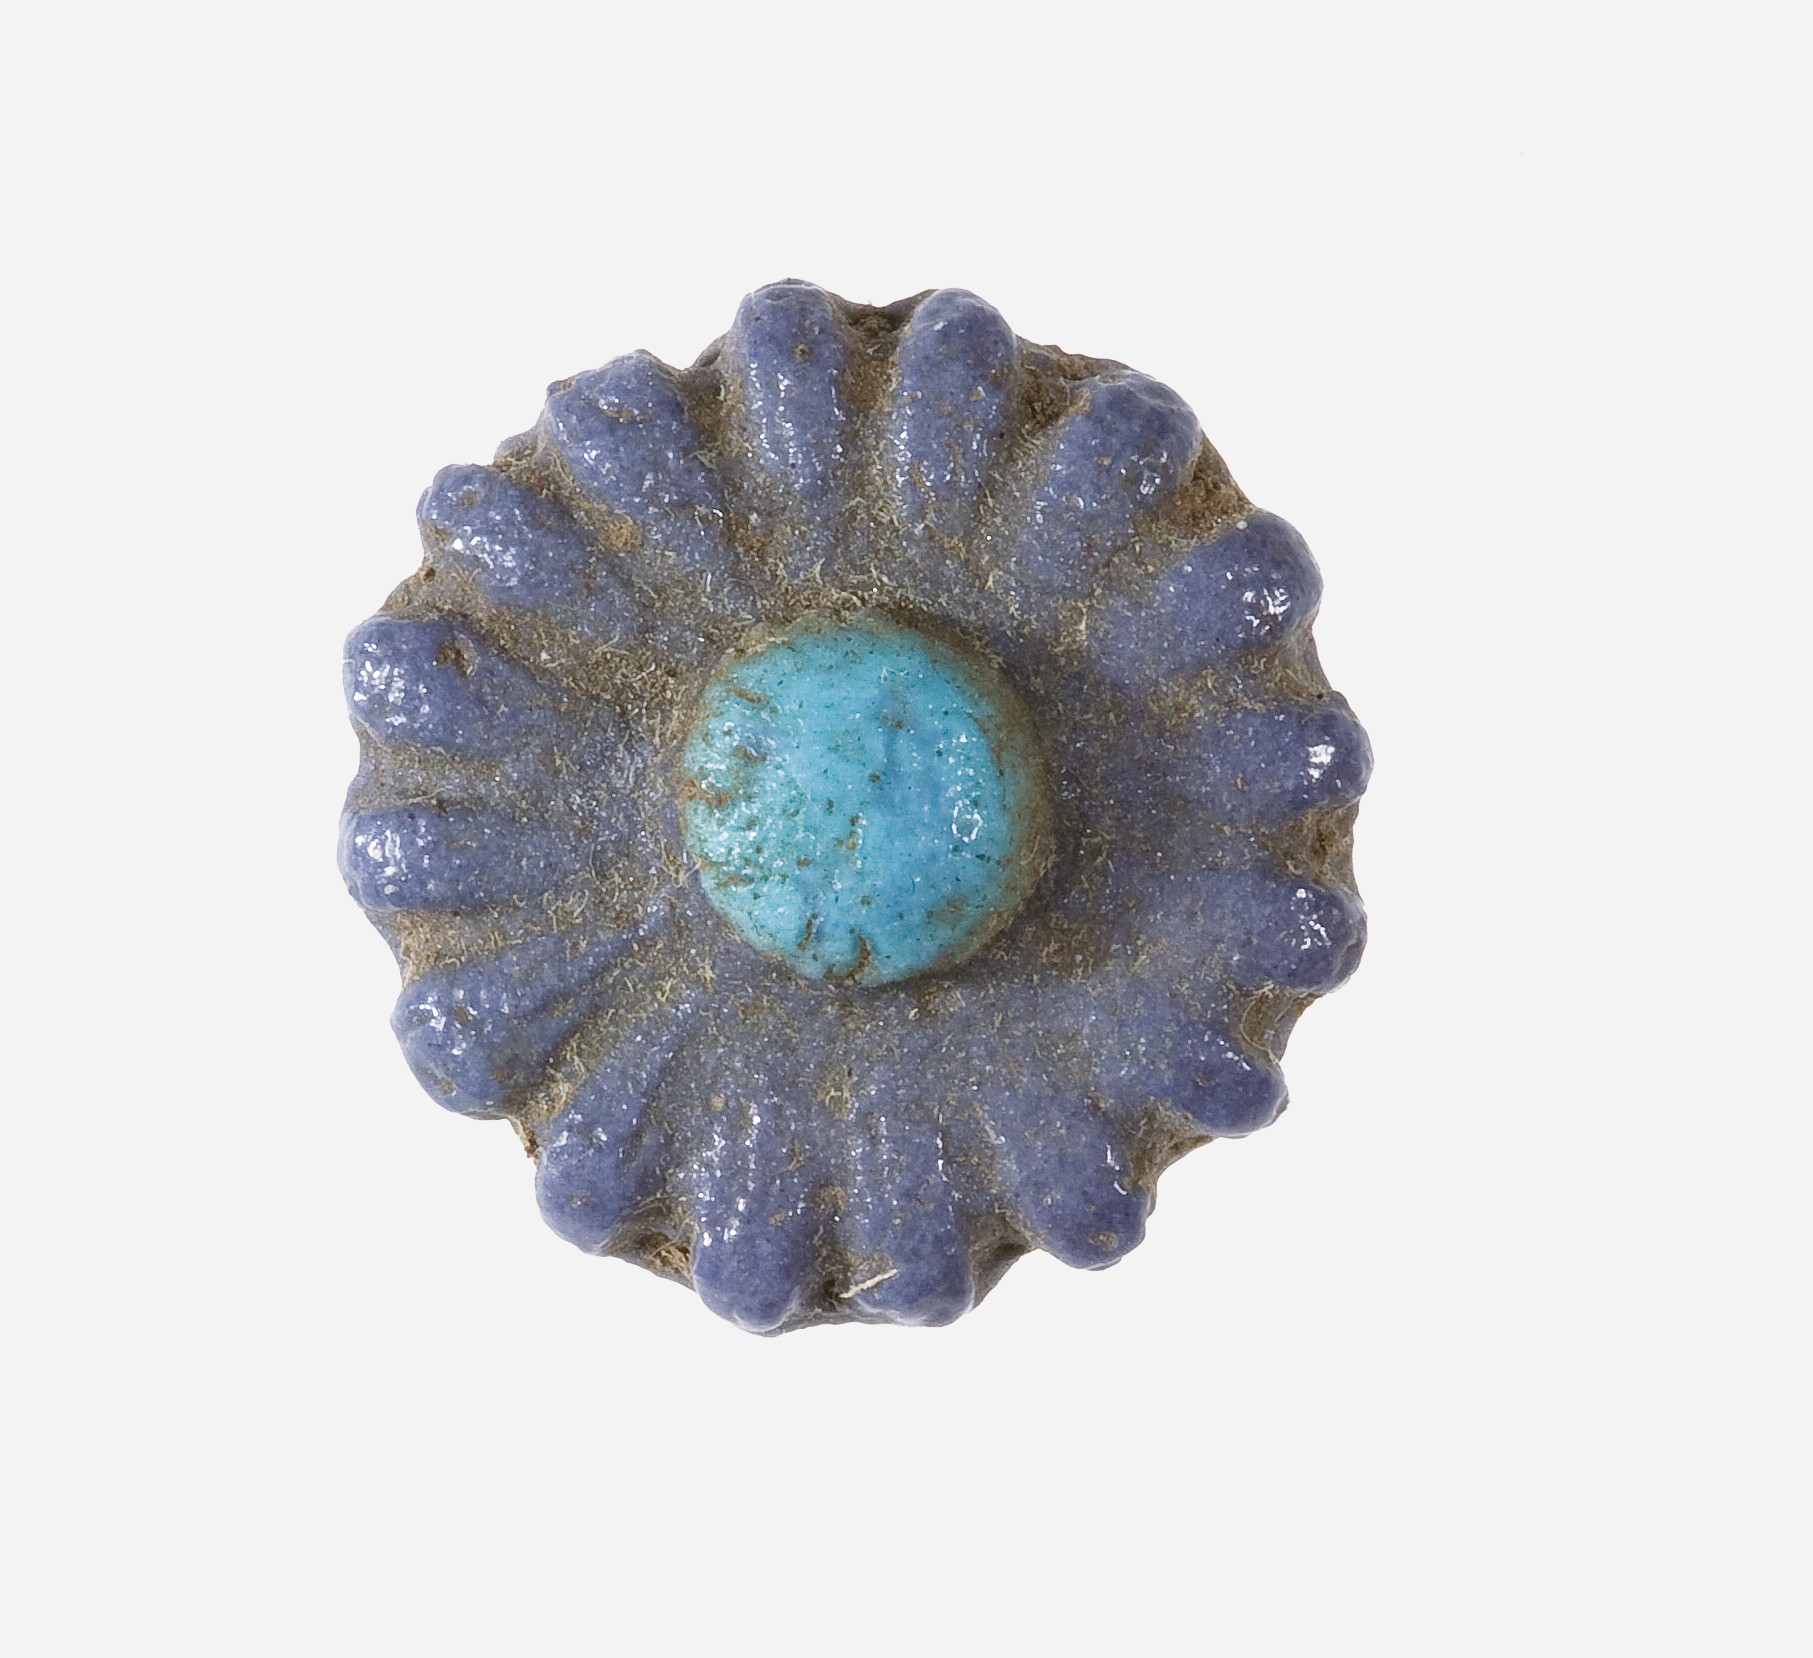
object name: bead, daisy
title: Daisy Bead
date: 1390-1352 BCE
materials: faience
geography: egypt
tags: daisies